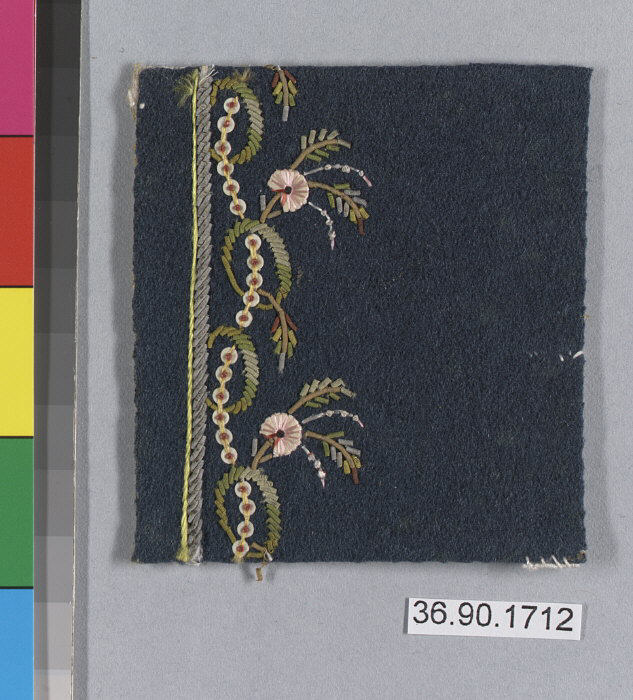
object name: sample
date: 1801-1833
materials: felt, metal thread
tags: flowers